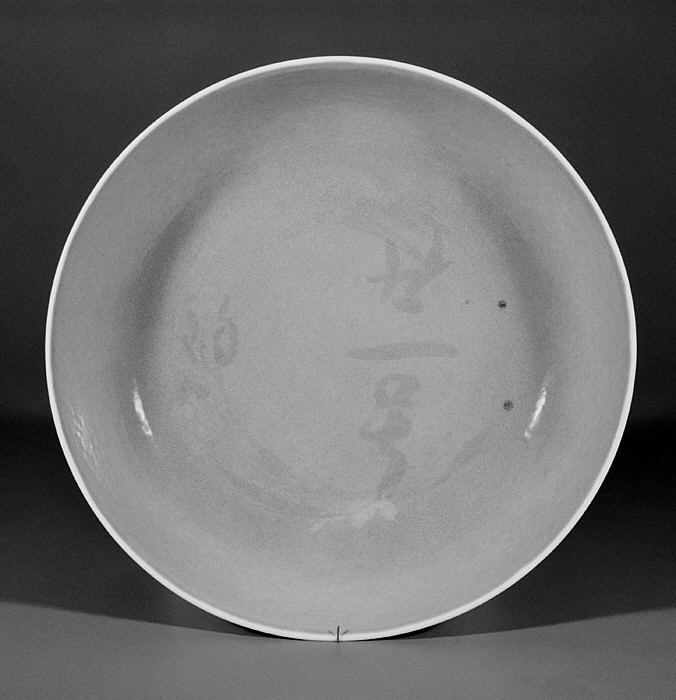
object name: dish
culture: chinese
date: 1867-1900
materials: glaze, porcelain